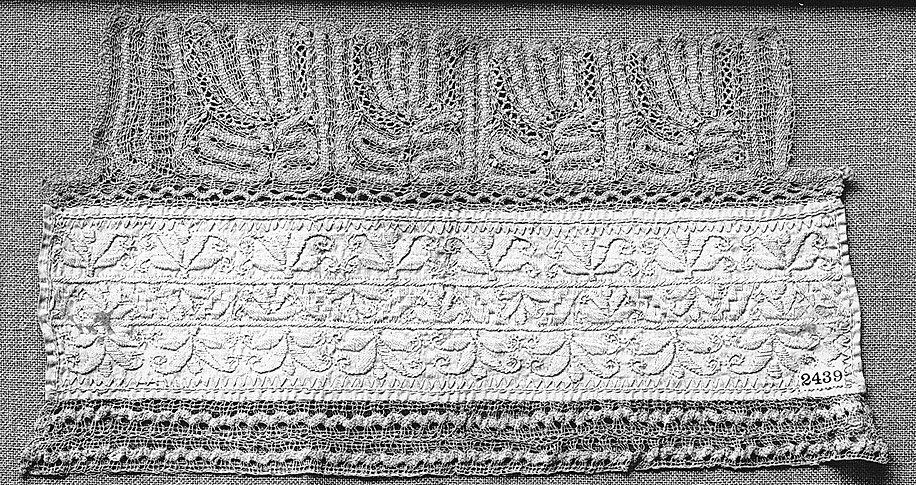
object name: cuff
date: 1801-1900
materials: linen, silk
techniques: lace